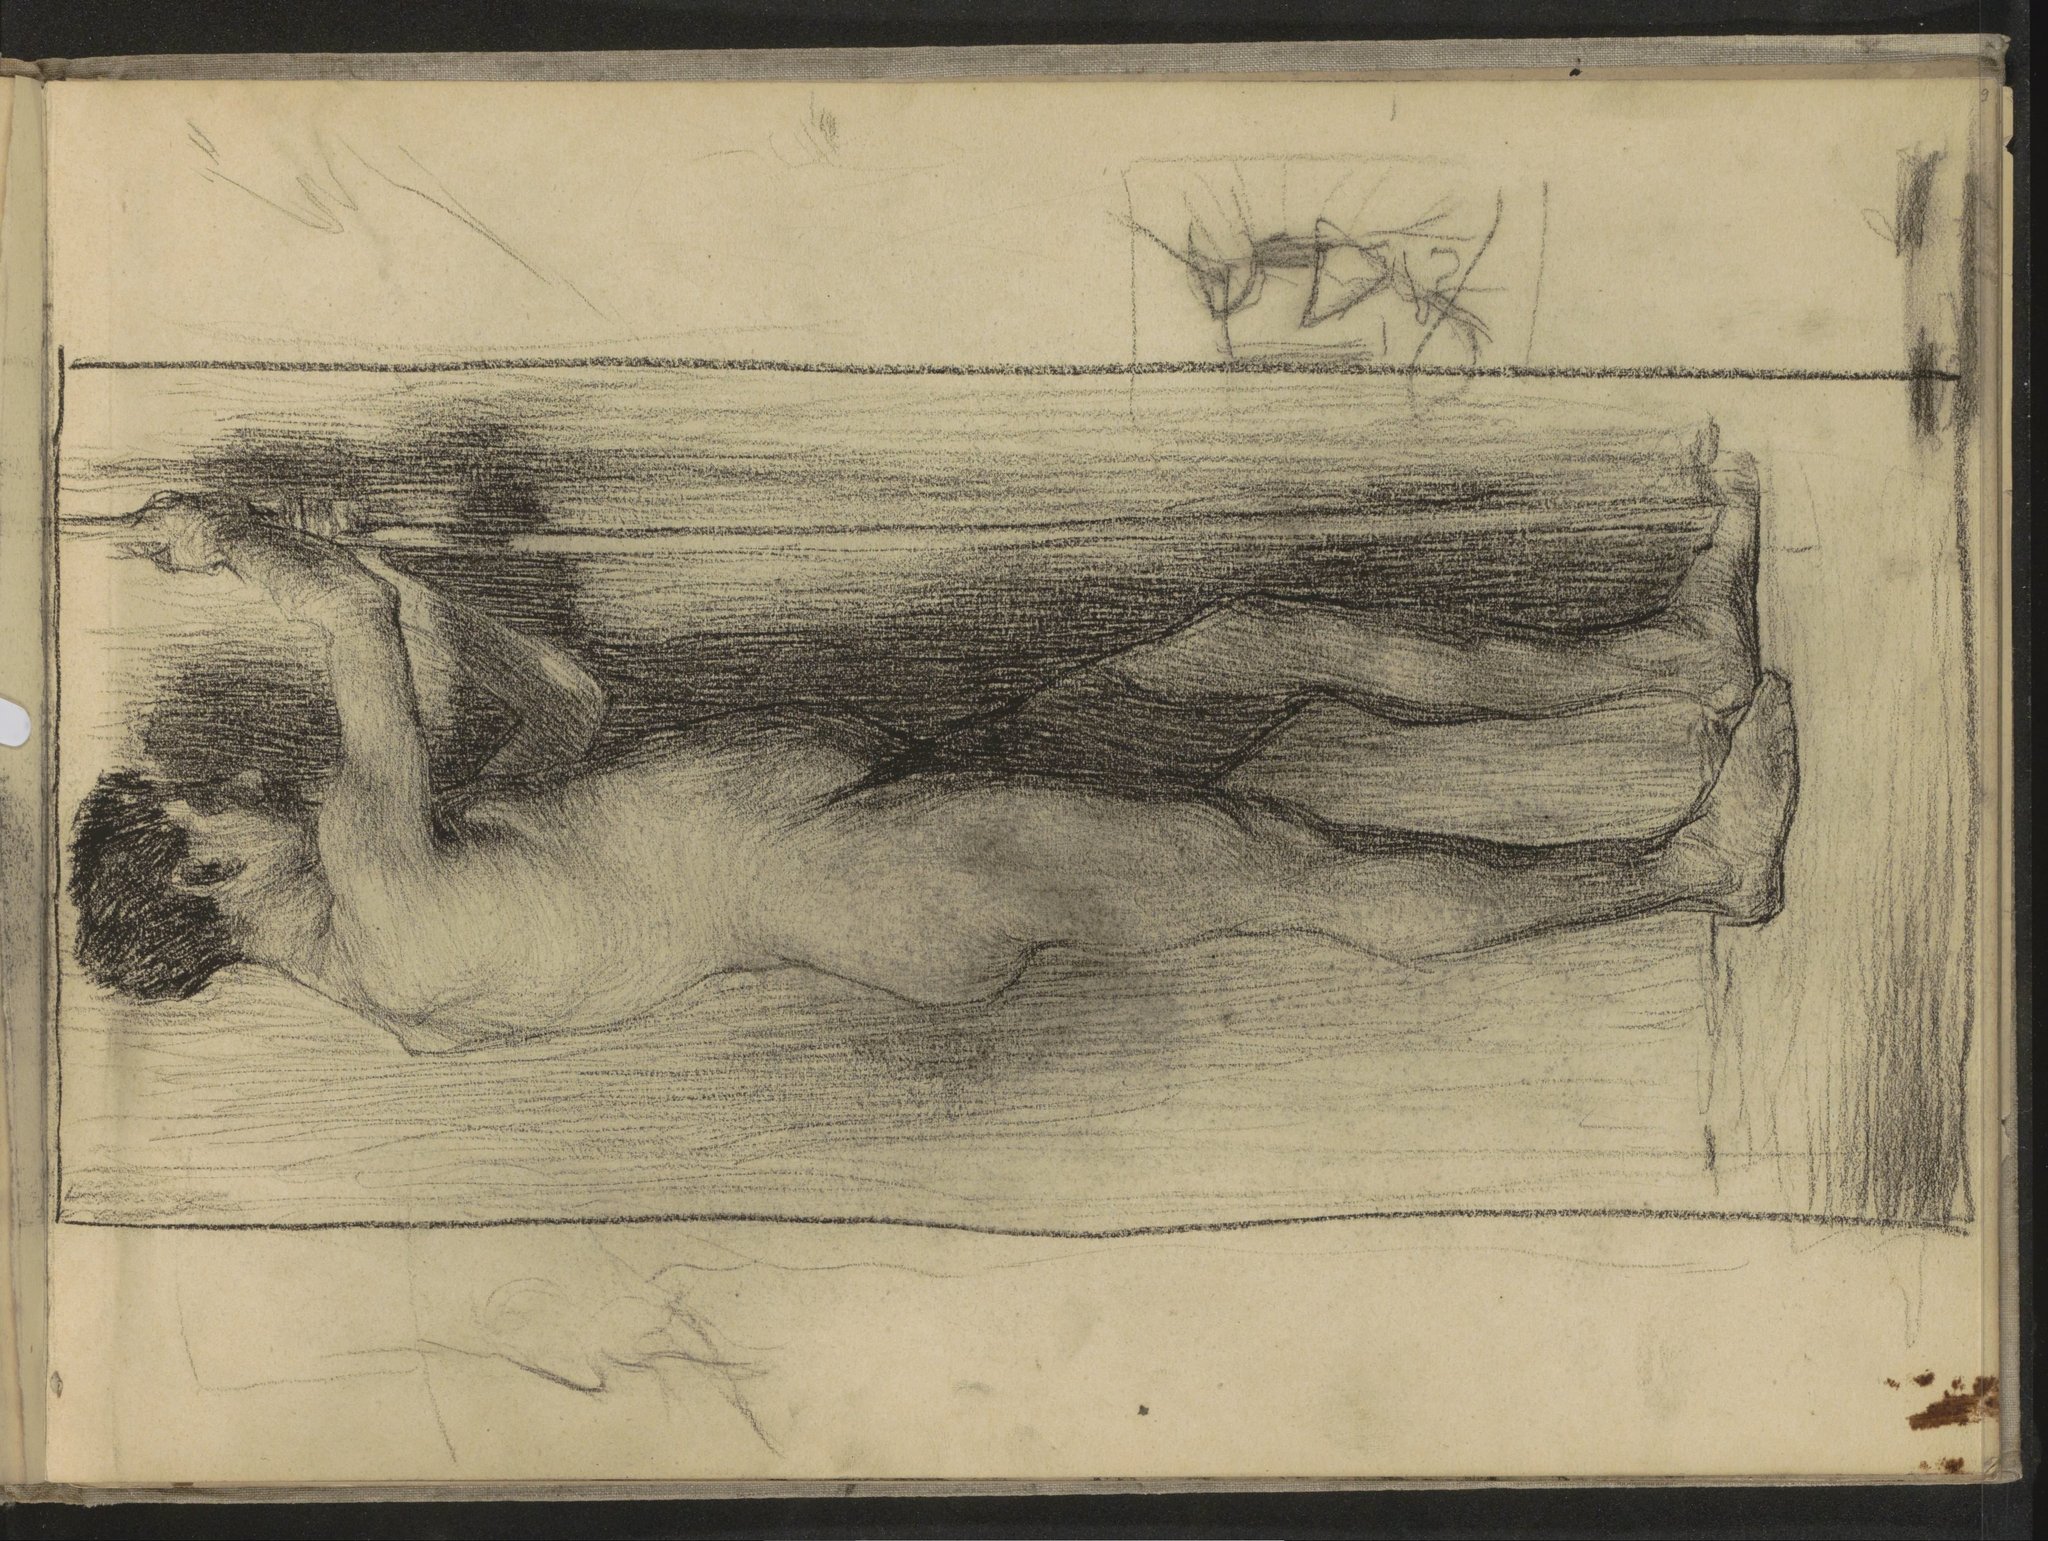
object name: sketchbook leaf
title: Staande naakte man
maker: marius bauer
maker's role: draughtsman, print maker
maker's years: 1867-1932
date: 1887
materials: chalk, paper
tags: standing figure, adult man, the (nude) human figure; 'corpo humano' (ripa) - aa - female human figure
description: De man is ten voeten uit en van opzij gezien getekend. Pagina 9 uit een schetsboek met 19 bladen.